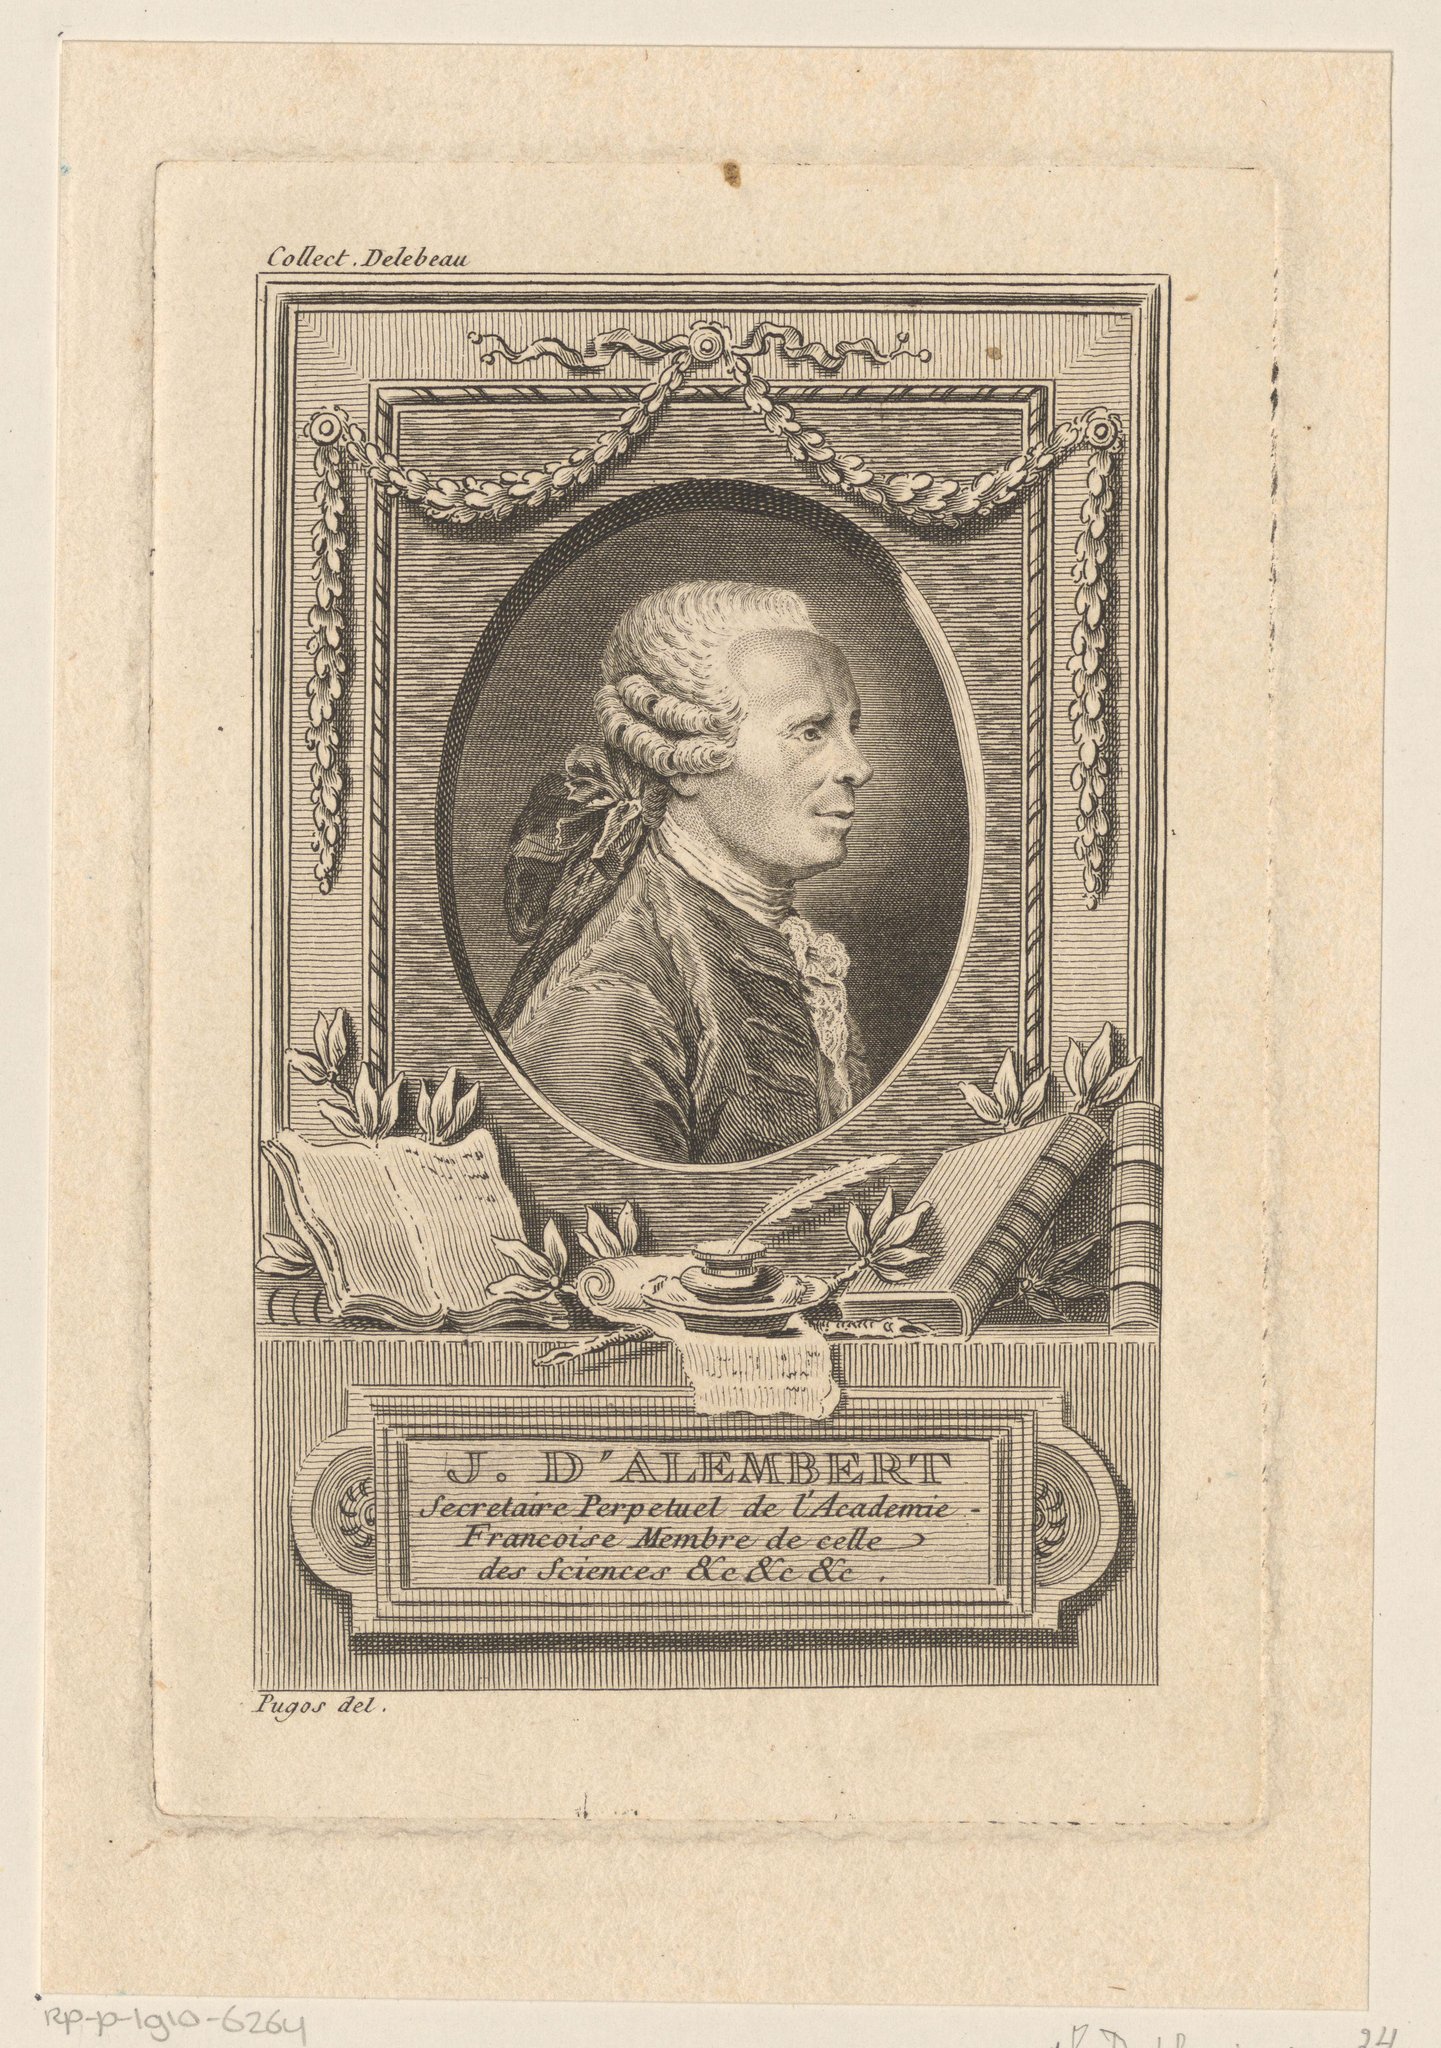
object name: print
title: Portret van Jean Le Rond d'Alembert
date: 1750-1849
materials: paper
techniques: engraving, etching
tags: physicist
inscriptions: collector's mark: Lugt 2228